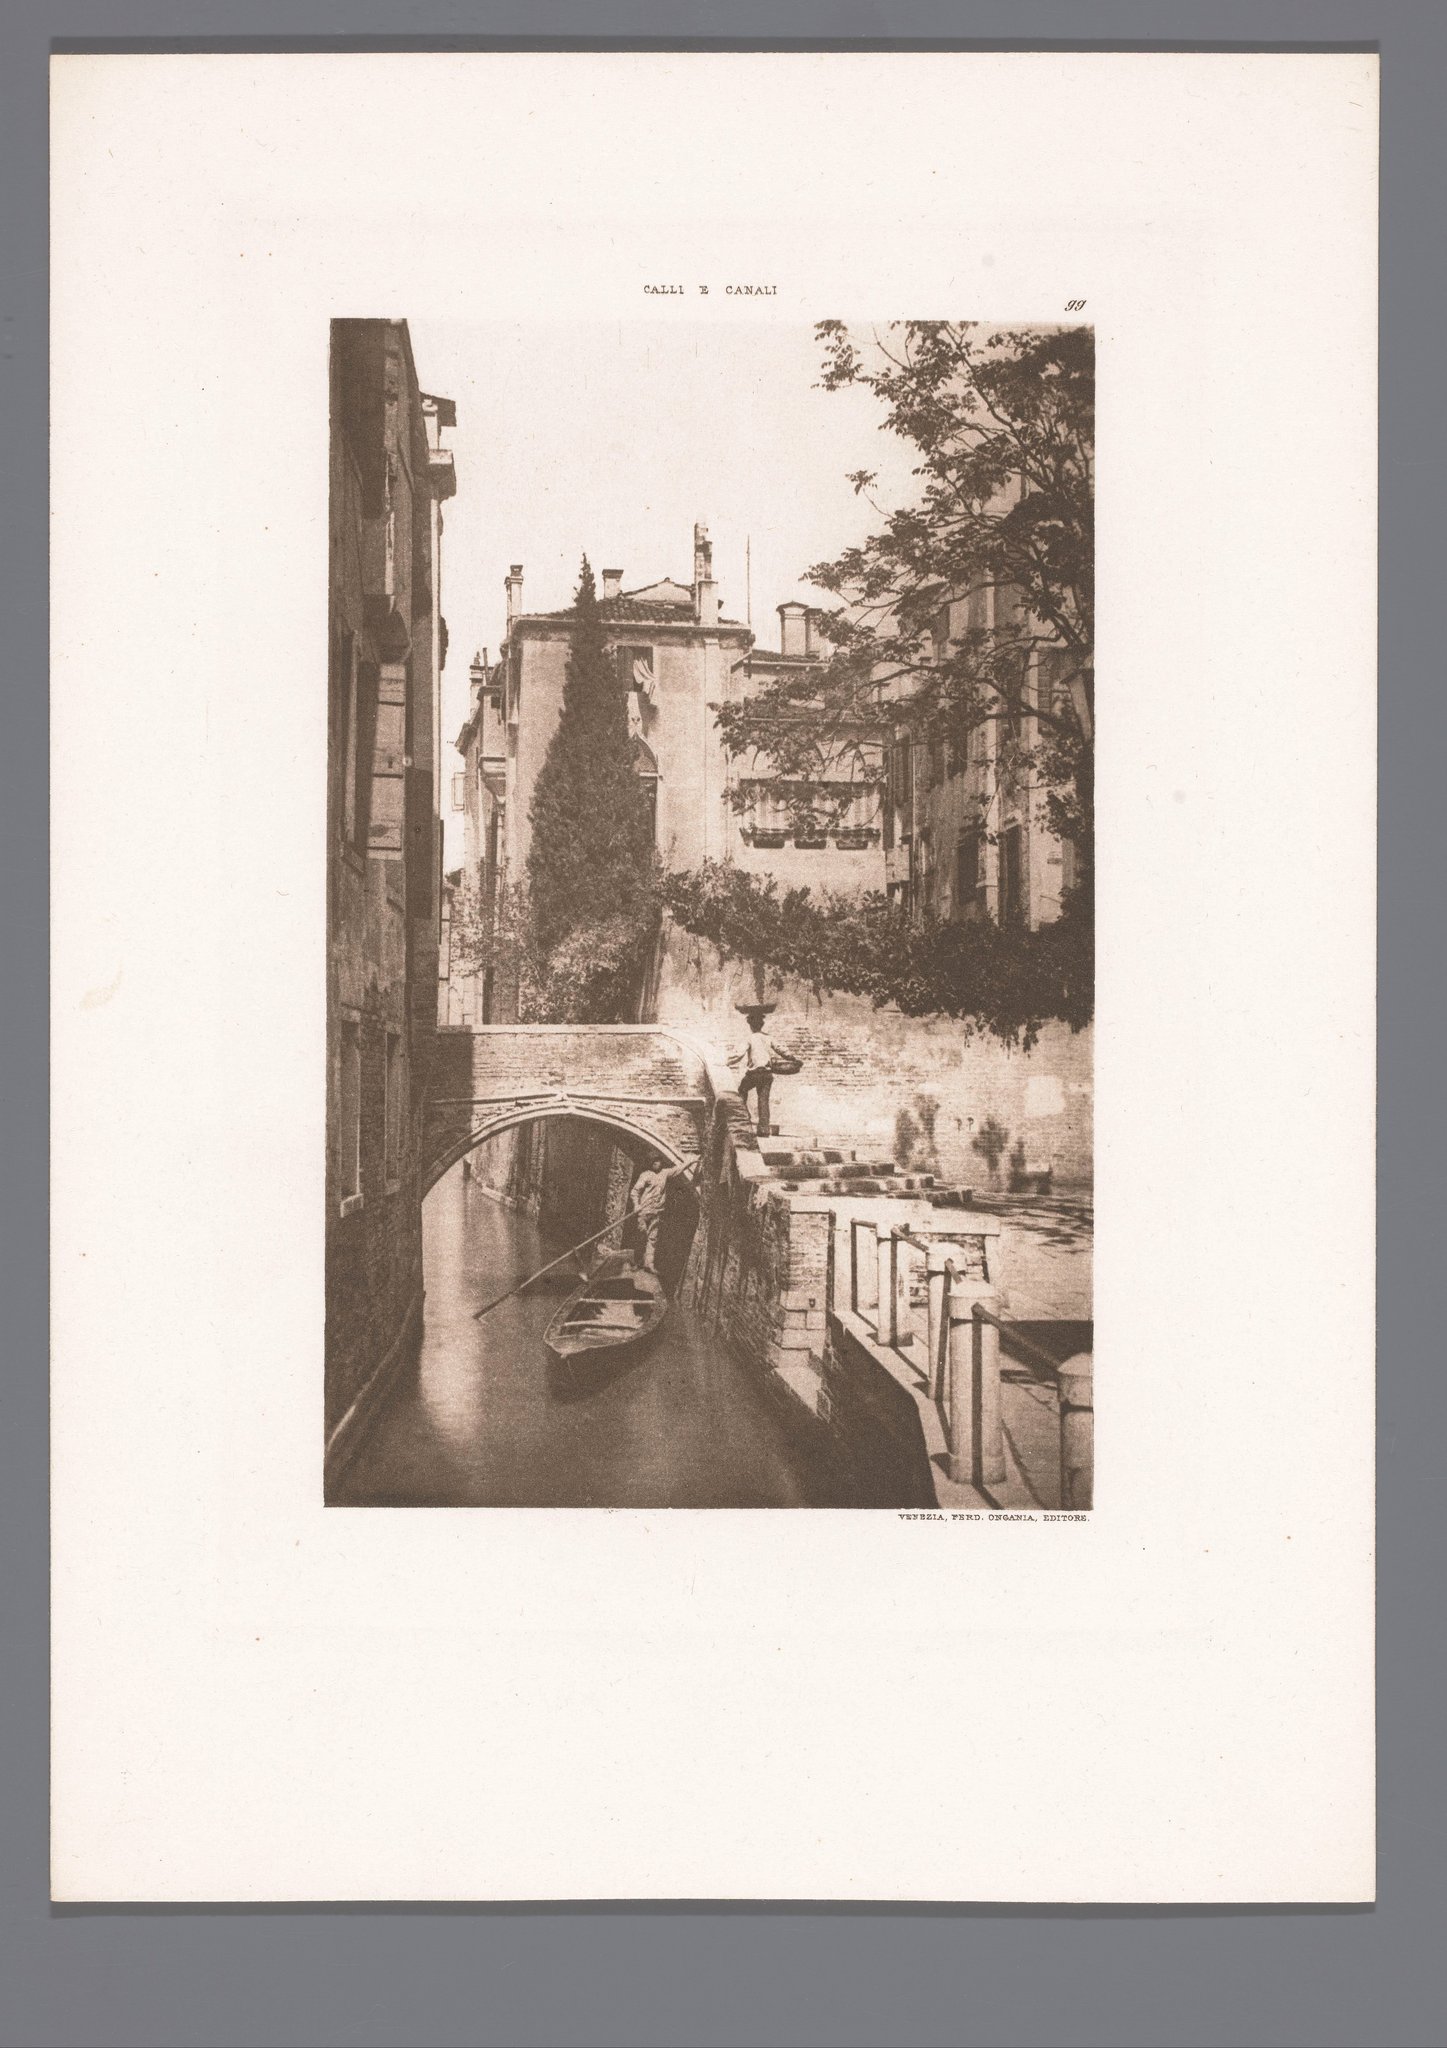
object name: page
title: Gezicht op een kanaal in Venetië met een gondel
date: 1888-1898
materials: paper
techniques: photoaquatint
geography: venice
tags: canals, waters (in city), gondola, venice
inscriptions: inscription: ‘gg’